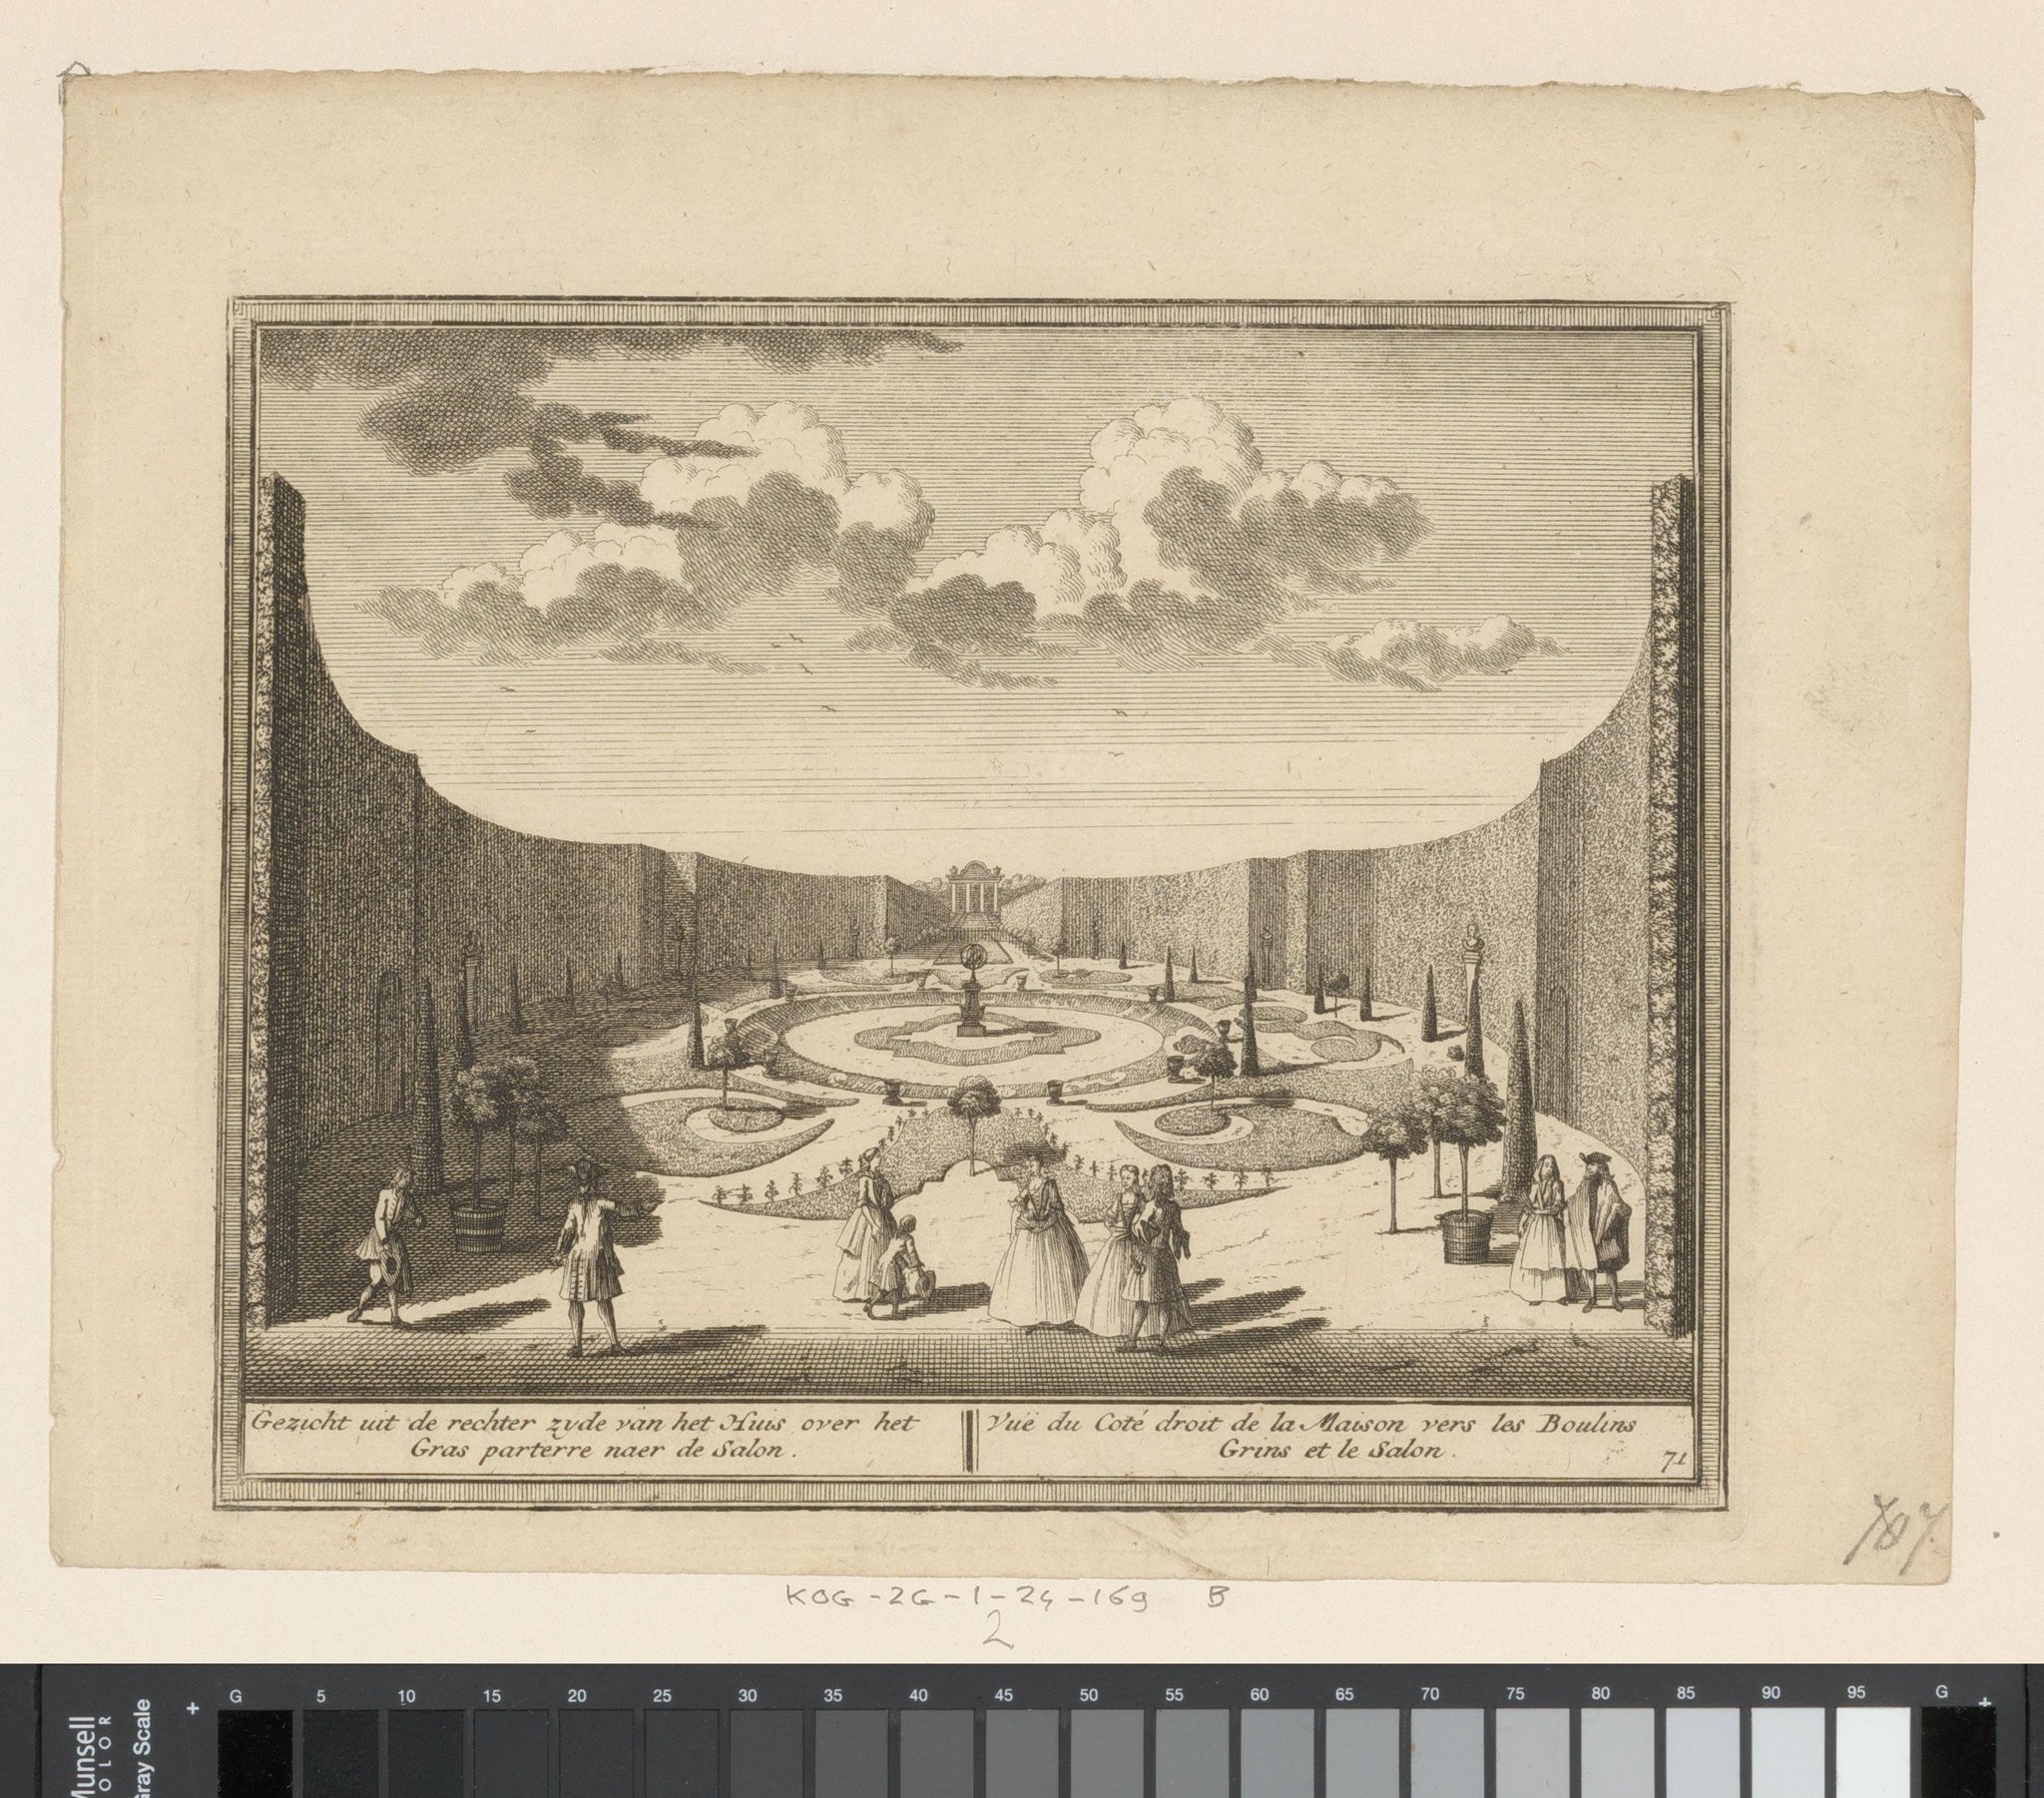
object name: print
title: Gezicht uit de rechter zijde van het Huis over het Gras parterre naer de Salon / Vuë du Coté droit de la Maison vers les Boulins Grins et le Salon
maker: hendrik de leth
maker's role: draughtsman, print maker, publisher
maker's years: 1703-1766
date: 1729-1732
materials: paper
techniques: engraving, etching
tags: french or architectonic garden; formal garden, country-house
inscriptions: stamp, stamp, collector's mark: Lugt 1641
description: Gezicht op de grasparterre met uitzicht op een paviljoen van het huis Velzerhooft, eigendom van Jacob du Peyrou Jansz. Rechtsonder genummerd: 71. Onderwerpsrubrieken binnen de Atlas Zeden en Gewoonten: Zeden en Gewoonten in Engeren Zin, De Woning, Oude Nederlandsche Tuinkunst. De 18de eeuw. Tuinen in Kennemerland, le Nôtre stijl.